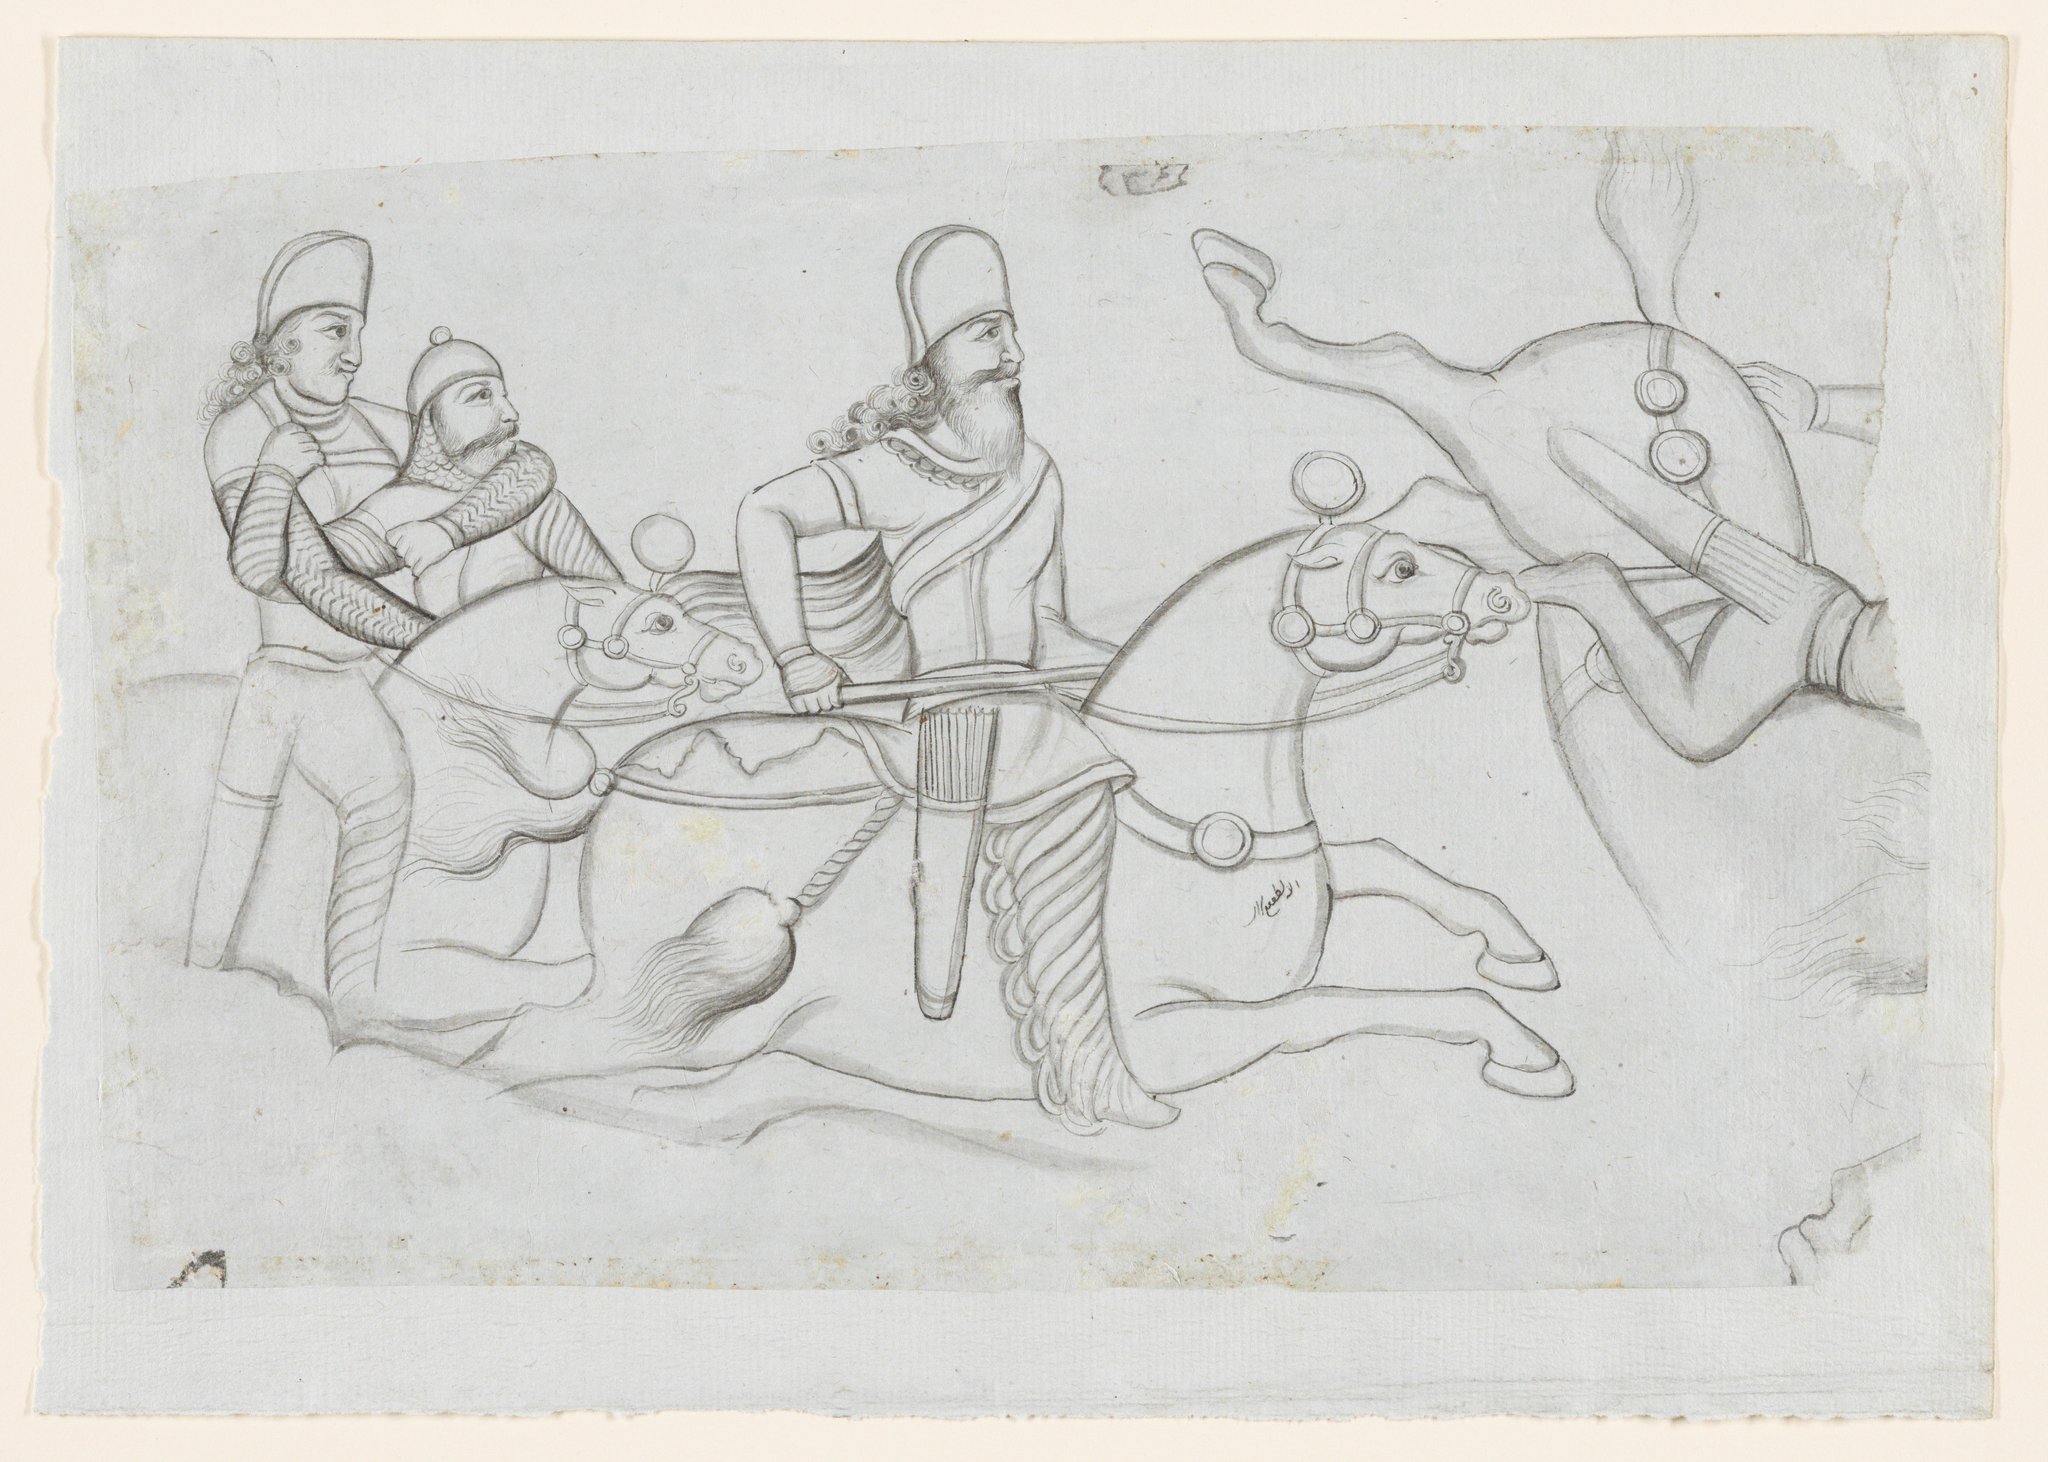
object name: drawing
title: Drawing of Sasanian rock relief: battle of Ardashir I (r. A.D. 224-241) at Firuzabad, southern Iran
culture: qajar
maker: lutf-'ali shirazi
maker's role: artist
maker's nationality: iranian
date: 1801-1833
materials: ink, paper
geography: iran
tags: soldiers,men,horses